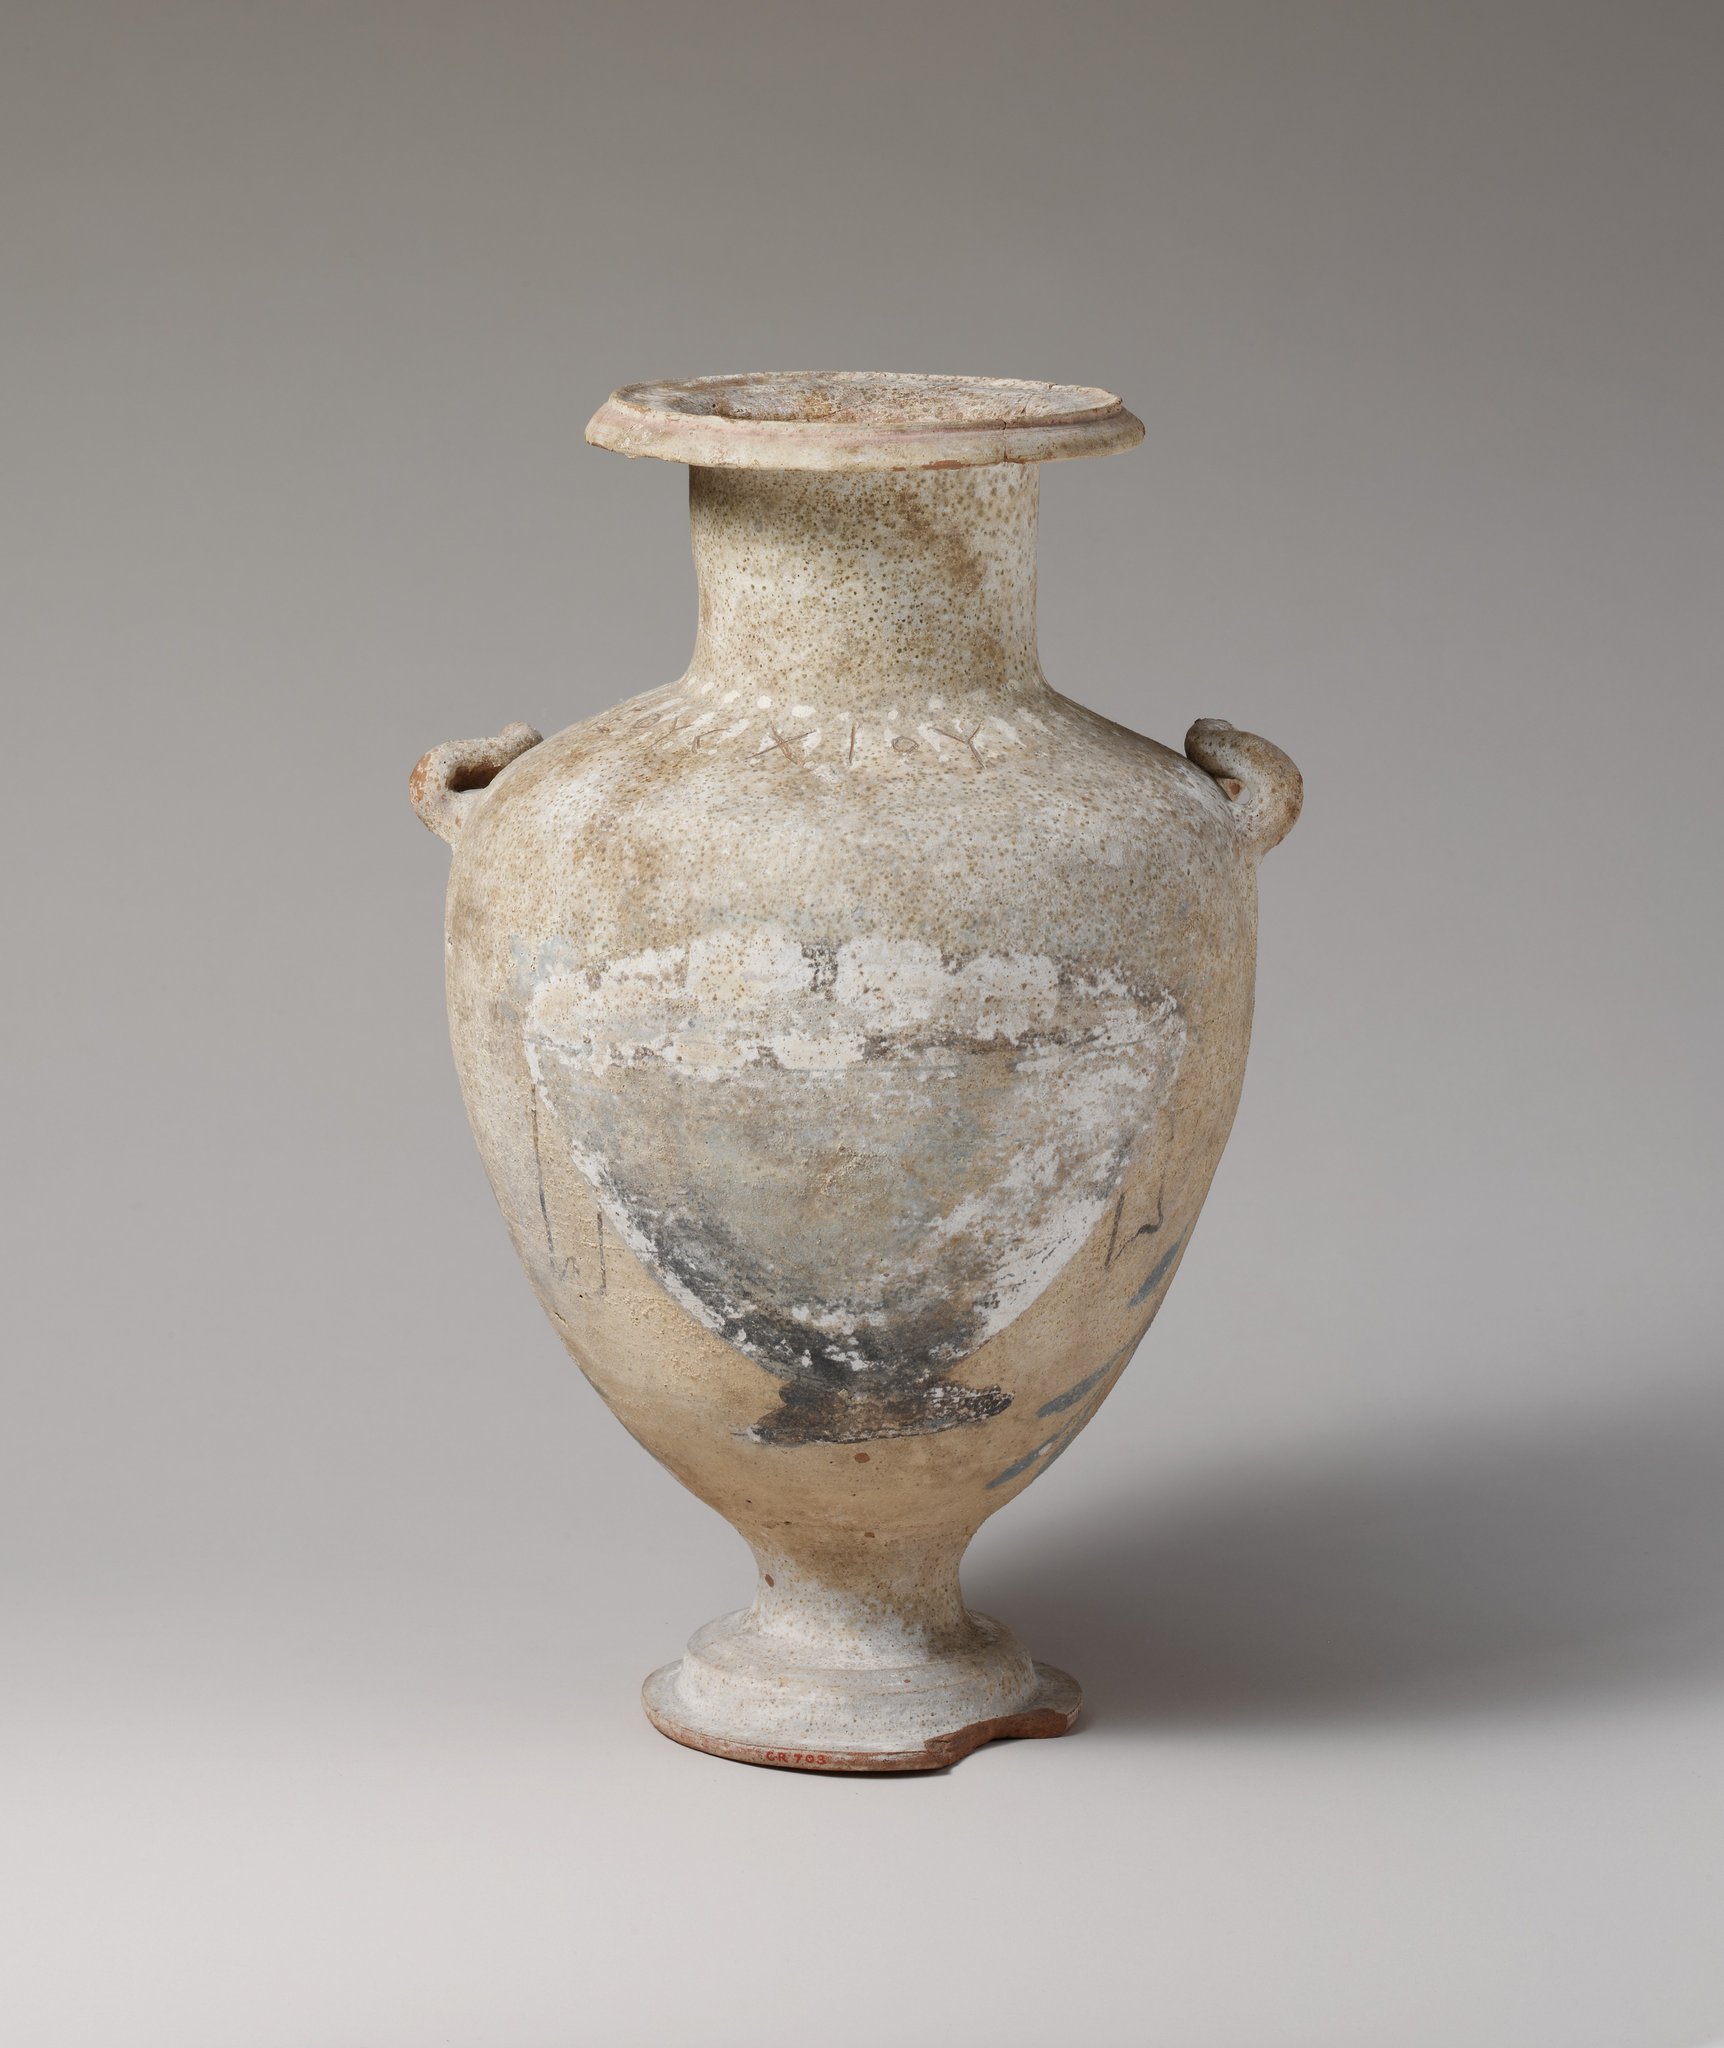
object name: hydria, hadra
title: Terracotta Hadra hydria (water jar)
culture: greek, ptolemaic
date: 300-201 BCE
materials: terracotta